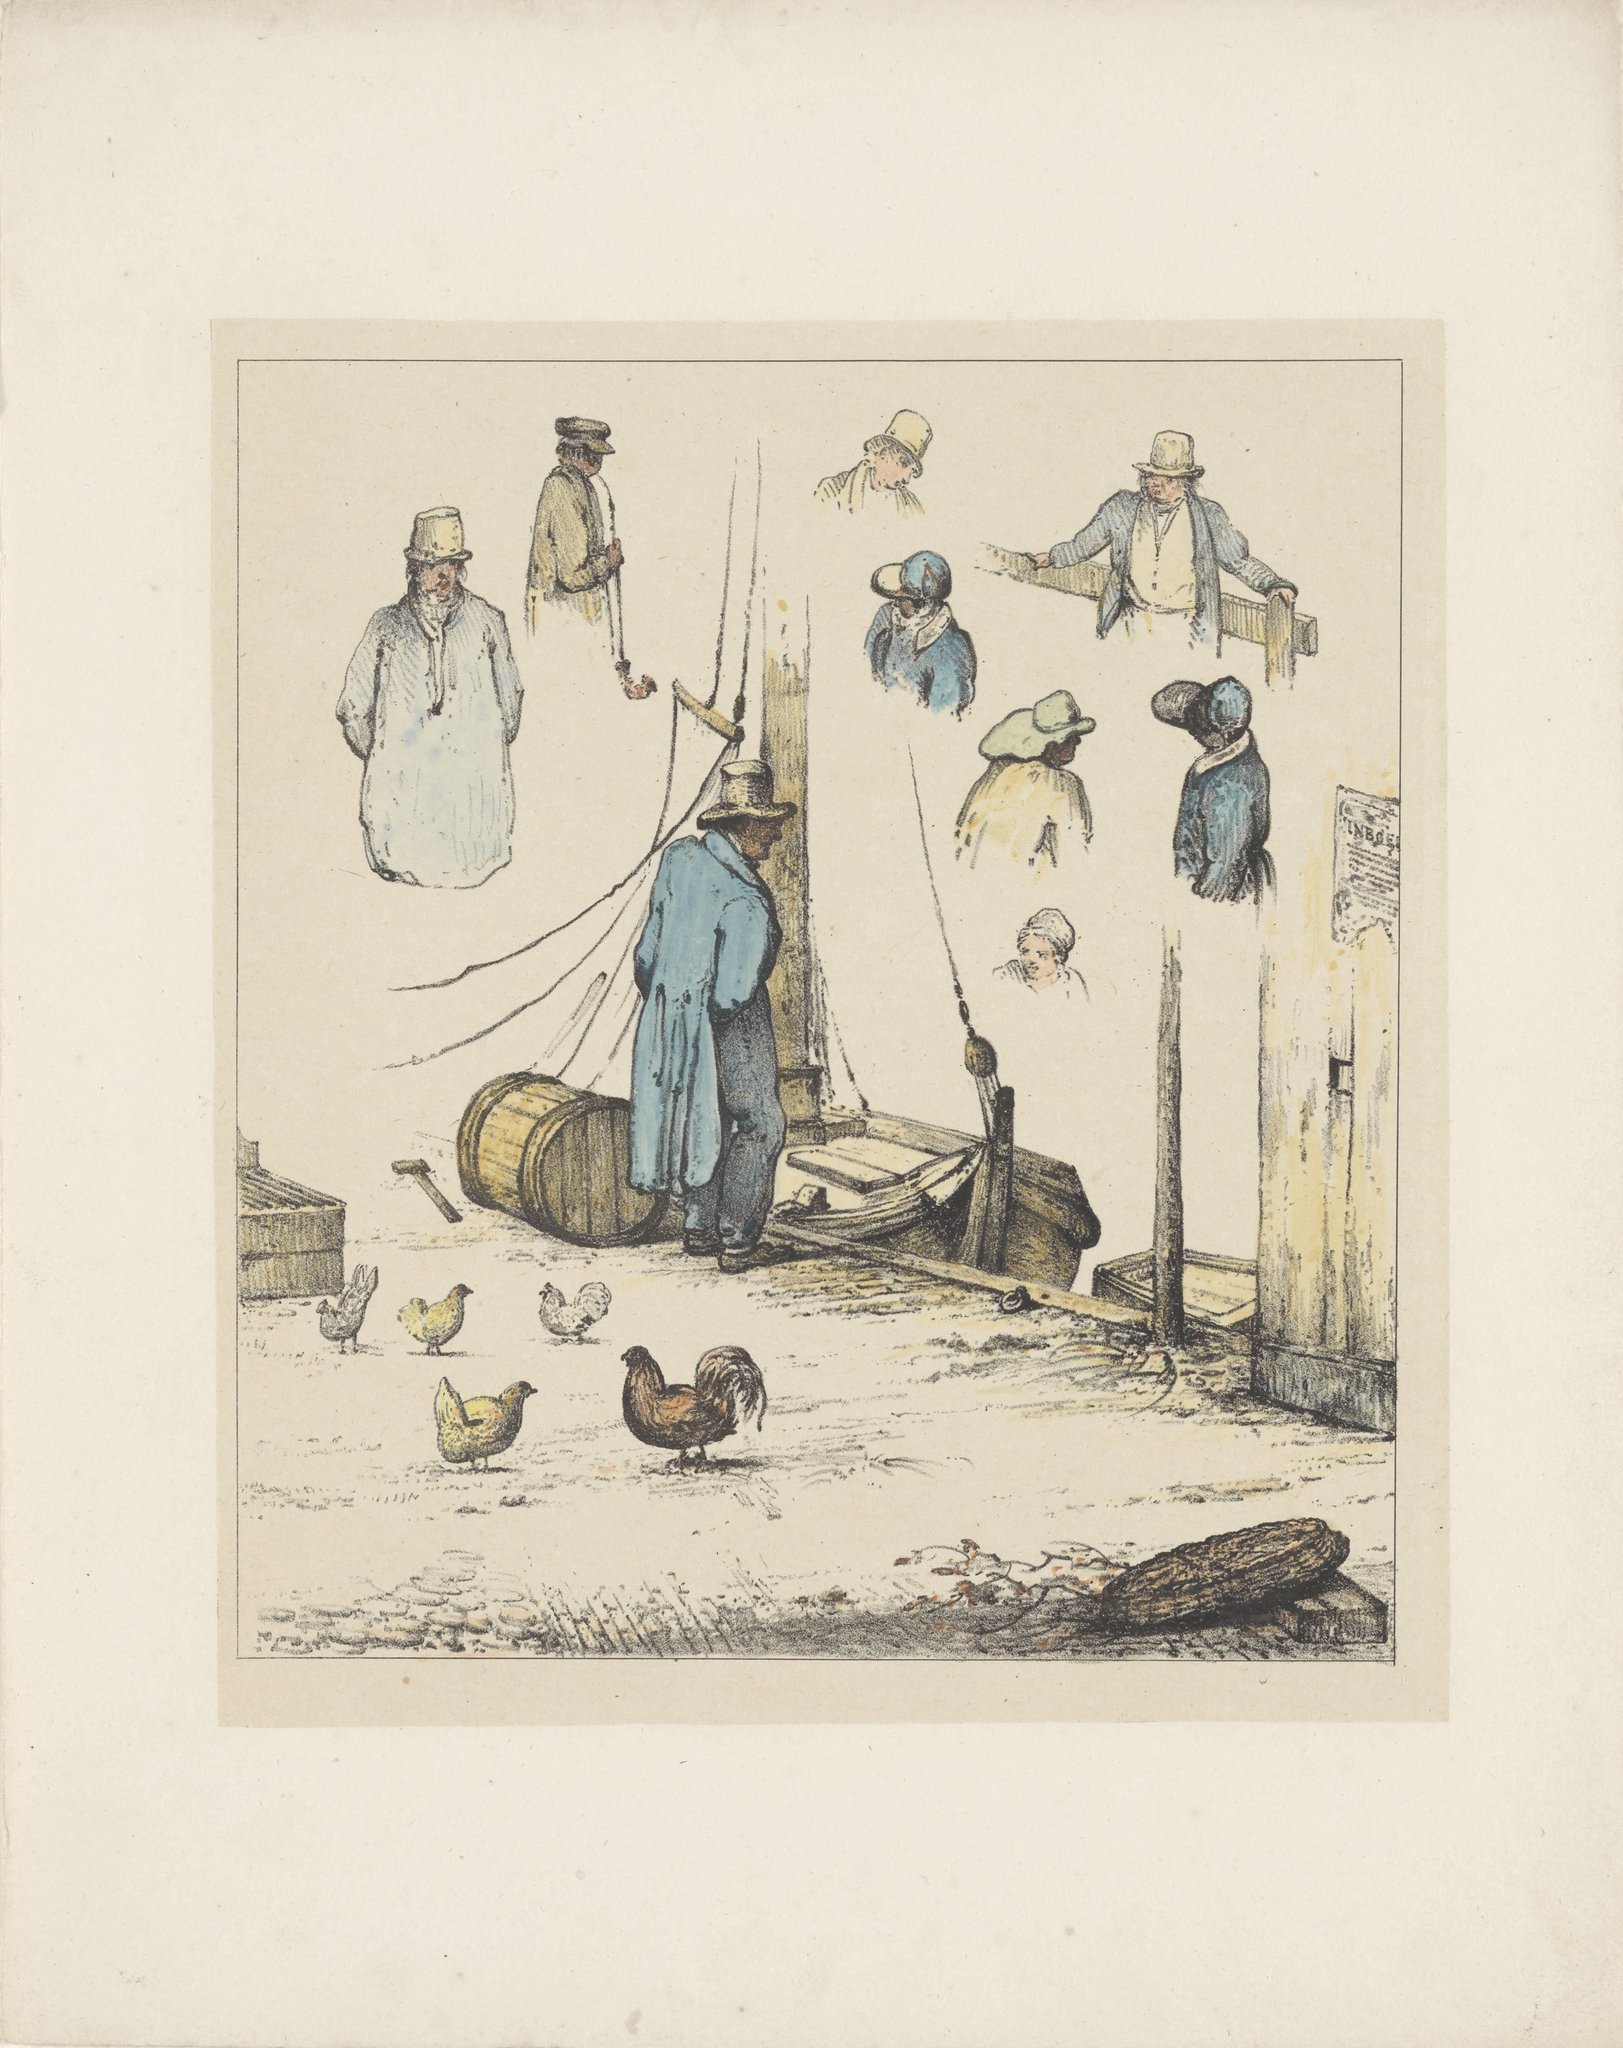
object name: print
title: Fragmenten van Nederlandsche kleederdragt, gebruiken, enz. Naar de natuur geteekend en gelithographieerd door C. Andriessen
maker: christiaan andriessen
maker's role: draughtsman, print maker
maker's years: 1775-1846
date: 1833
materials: paper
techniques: hand coloring, lithograph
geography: netherlands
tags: street-trader, folk costume, regional costume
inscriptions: collector's mark: Lugt 2228, collector's mark: Lugt 2760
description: Blad met figuren: een man staande bij een kade, op de voorgrond scharrelen kippen. Onderdeel van een serie van zes bladen met figuurstudies van Nederlandse klederdrachten, straatfiguren en gebuiken, 1833.